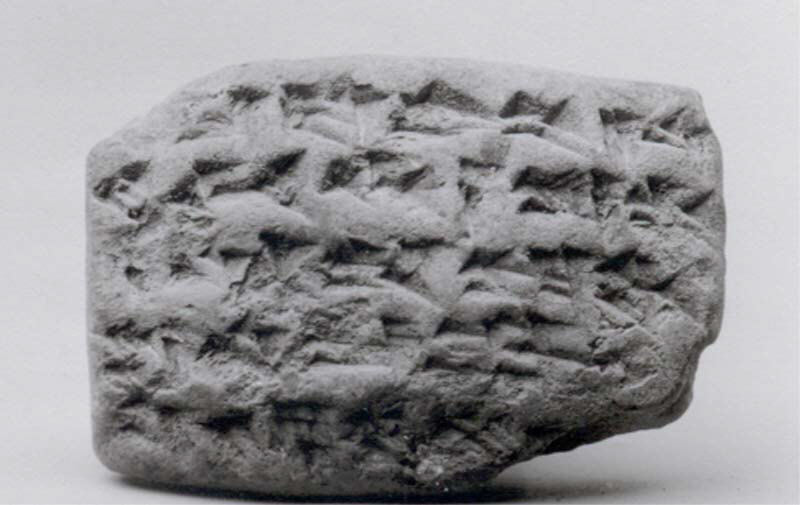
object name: cuneiform tablet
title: Cuneiform tablet: record of silver for supplies, Ebabbar archive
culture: babylonian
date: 575 BCE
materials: clay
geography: mesopotamia